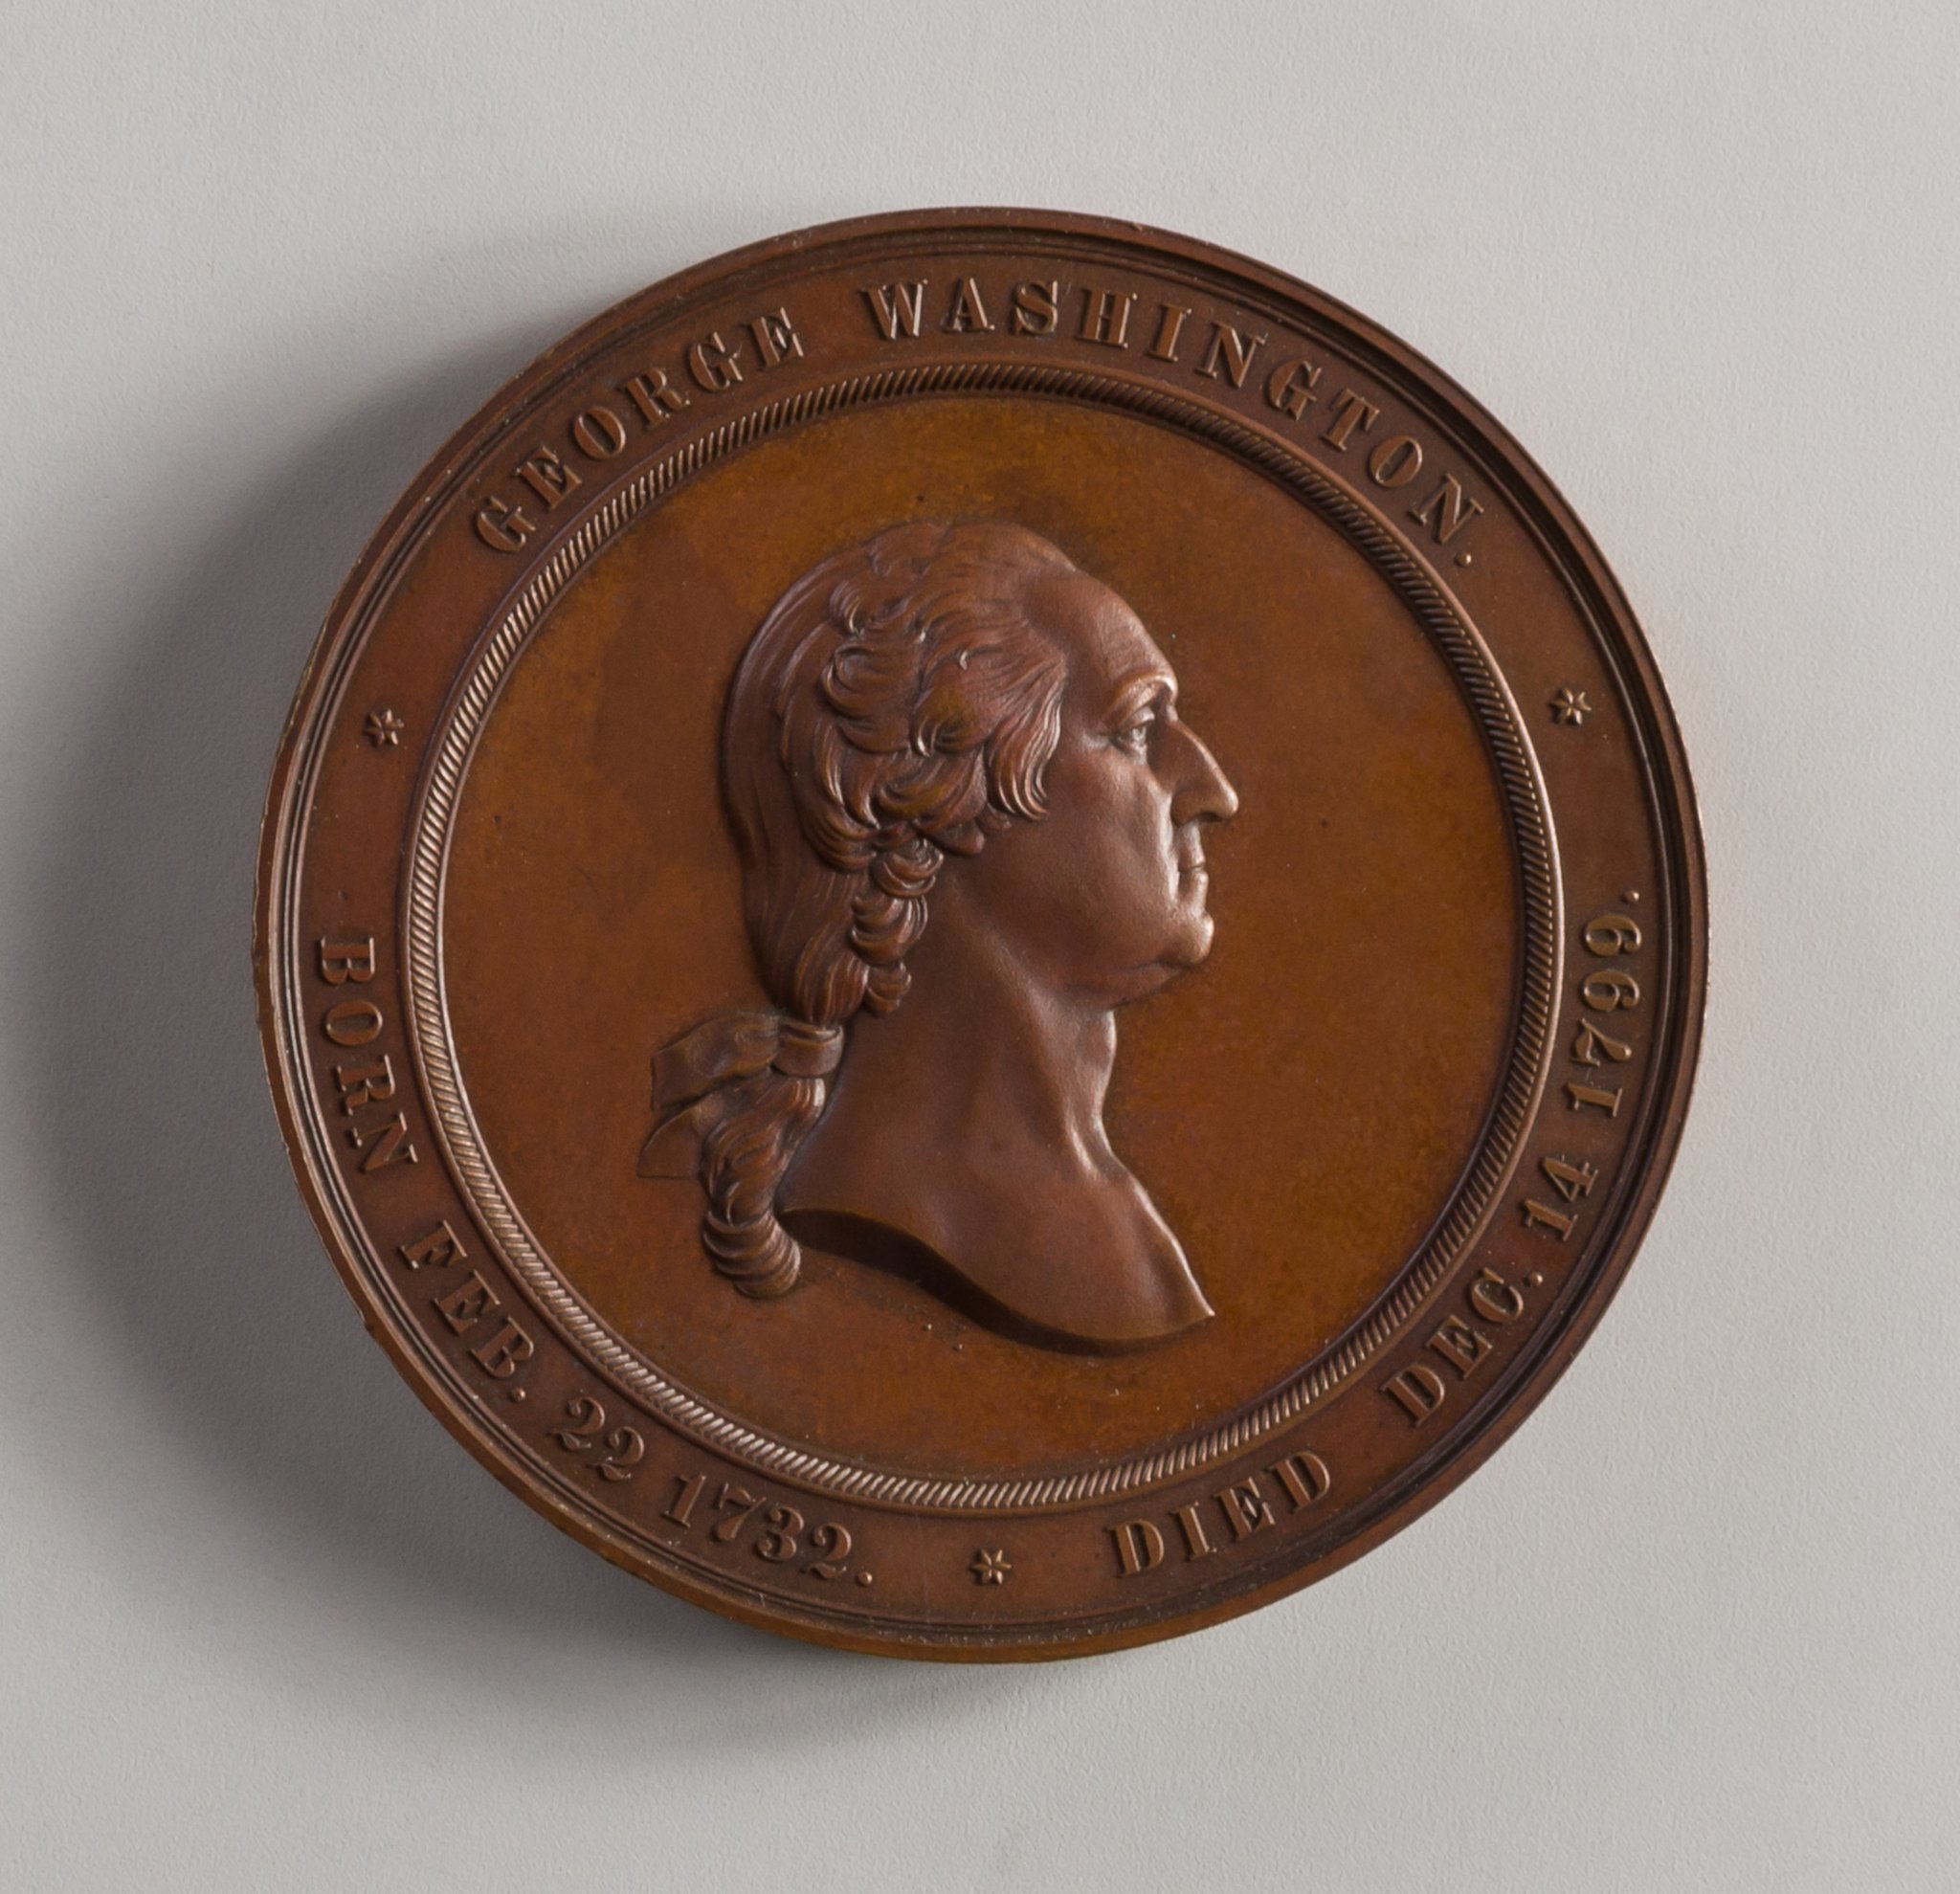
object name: medal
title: Medal of the Inauguration of the Washington Cabinet of Medals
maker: anthony paquet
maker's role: maker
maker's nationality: american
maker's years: 1814-1882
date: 1860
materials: bronze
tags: george washington,profiles